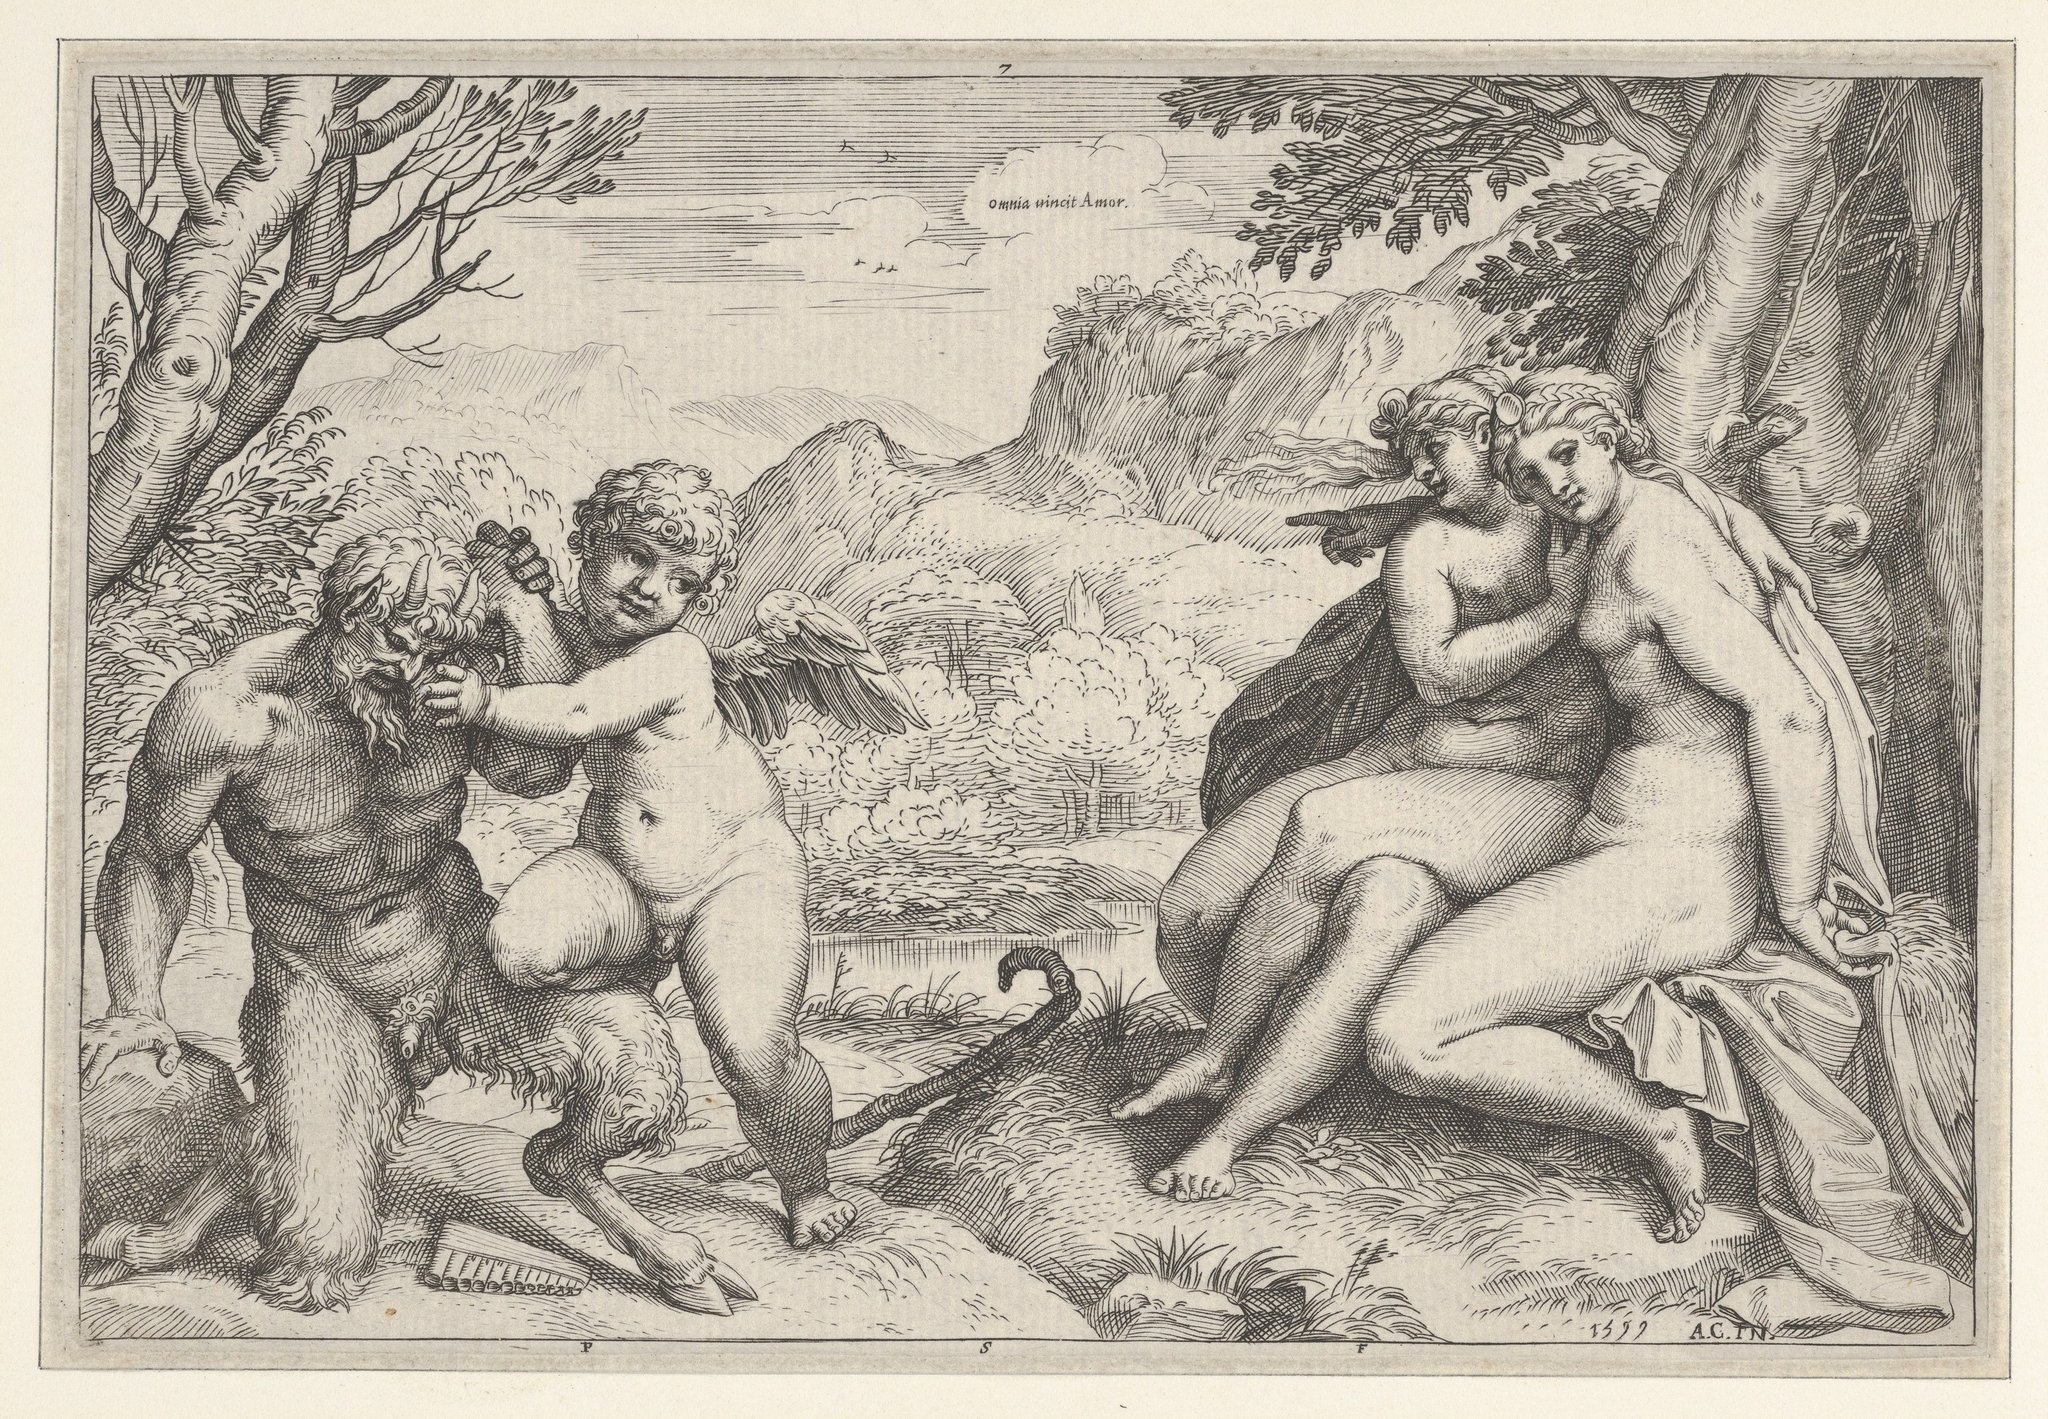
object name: print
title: Omnia Vincit Amor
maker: agostino carracci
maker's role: artist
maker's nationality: italian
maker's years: 1557-1602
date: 1599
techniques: engraving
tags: female nudes,cupid,nymphs,pan